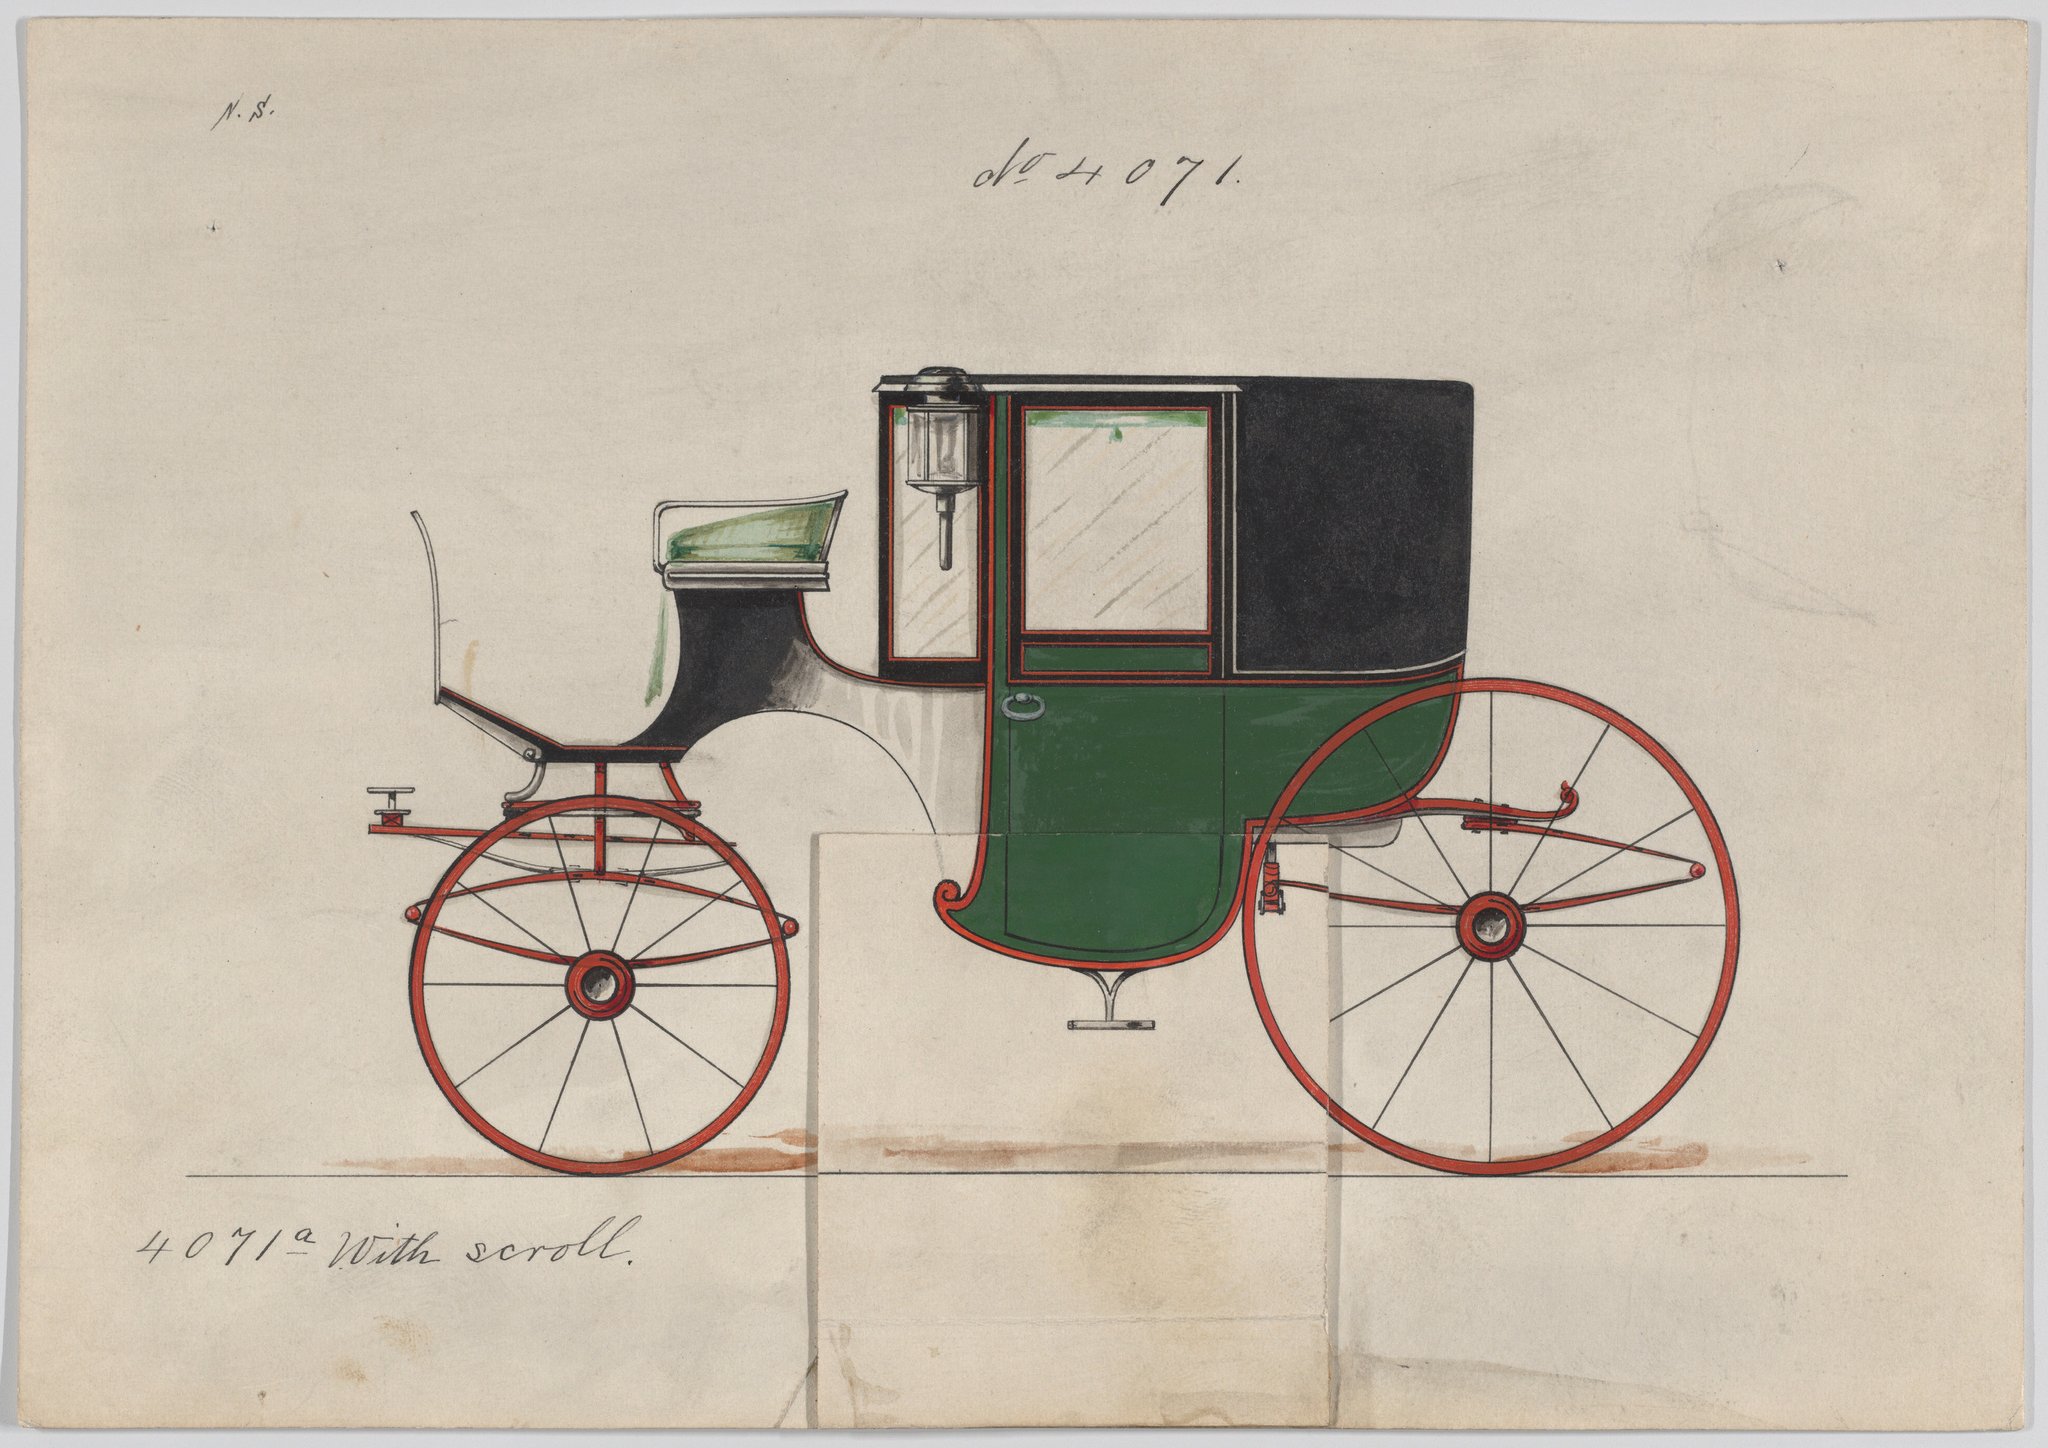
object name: drawing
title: Design for Coupé, no. 4071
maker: brewster & co.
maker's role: manufacturer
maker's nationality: american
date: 1890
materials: gouache, gum arabic, ink, watercolor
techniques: pen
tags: carriages